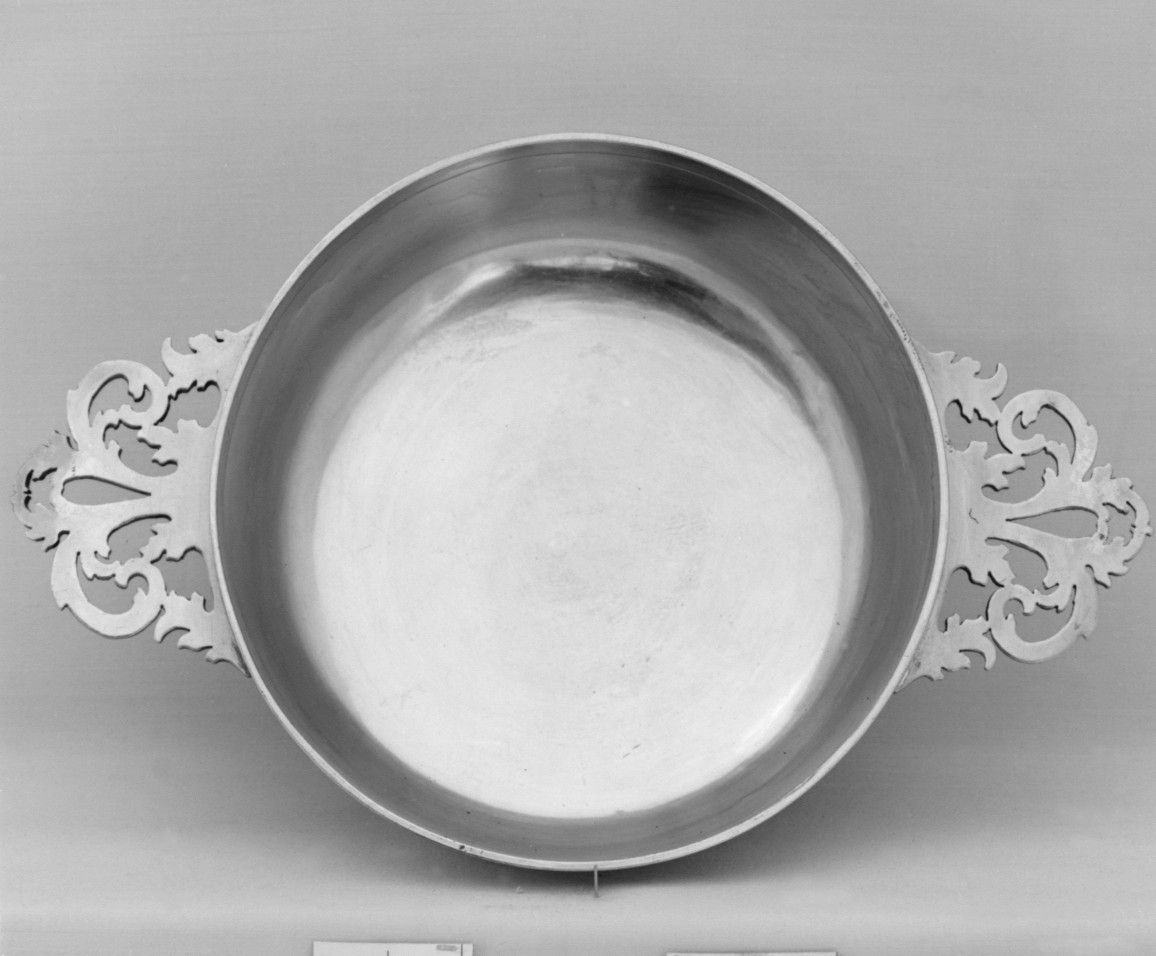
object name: porringer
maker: johann christoph hünning i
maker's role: maker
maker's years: 1637-1737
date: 1701-1733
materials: silver gilt